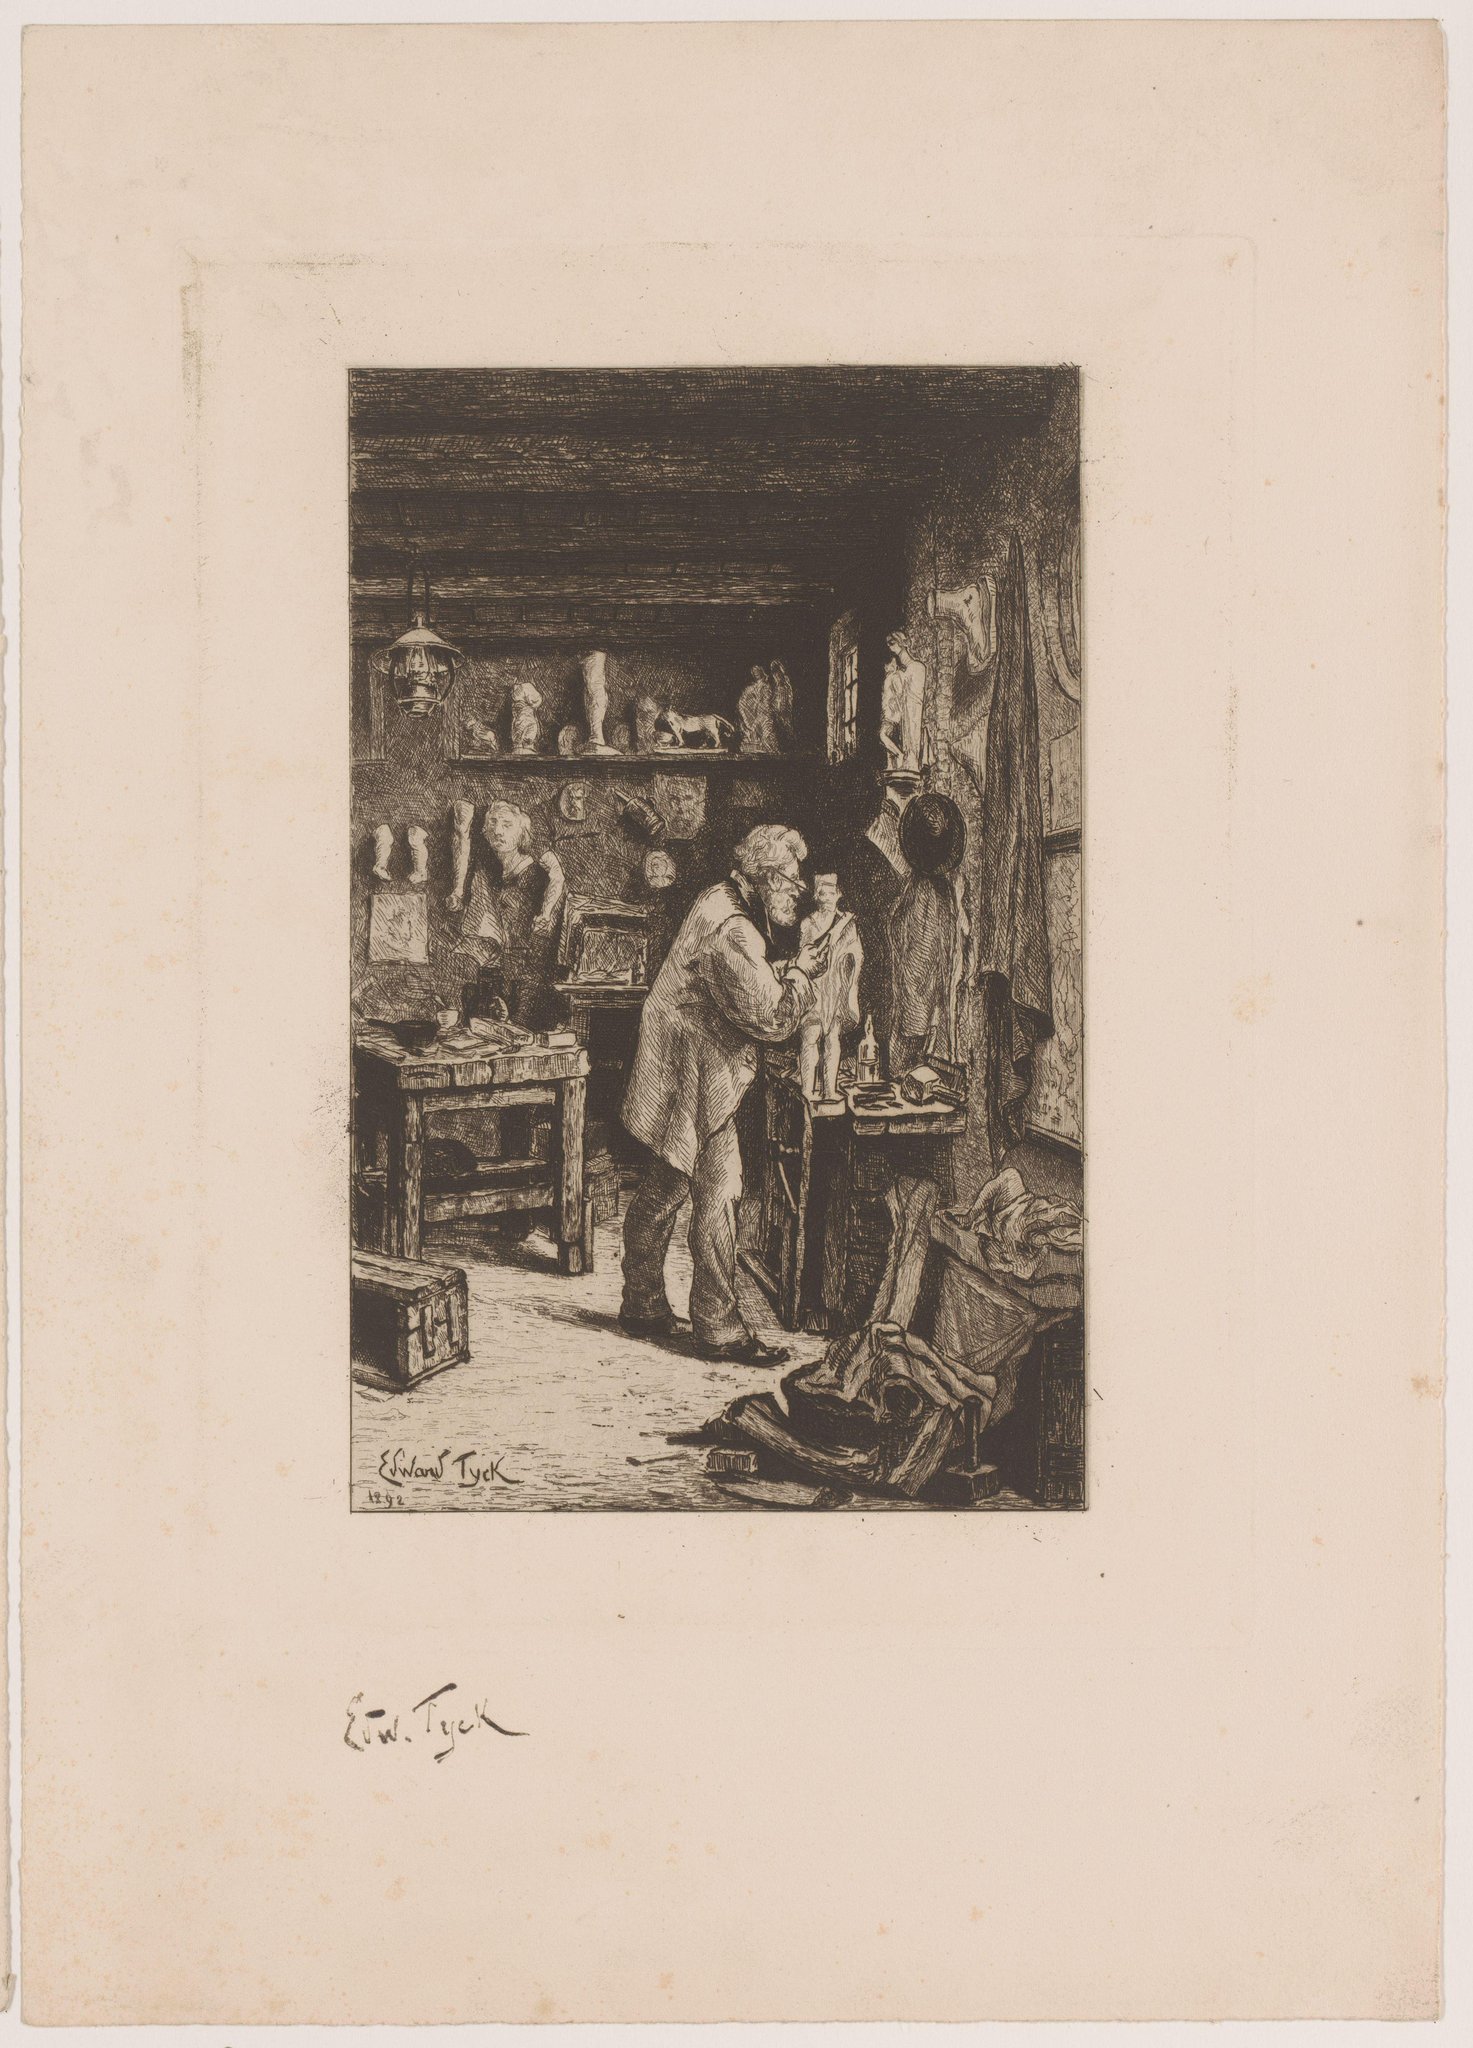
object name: print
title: Beeldhouwer in zijn werkplaats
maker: edouard tyck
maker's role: print maker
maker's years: 1847-1922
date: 1892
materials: paper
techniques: drypoint, etching, intaglio, retroussage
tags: sculptor at work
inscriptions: collector's mark: Lugt 2228